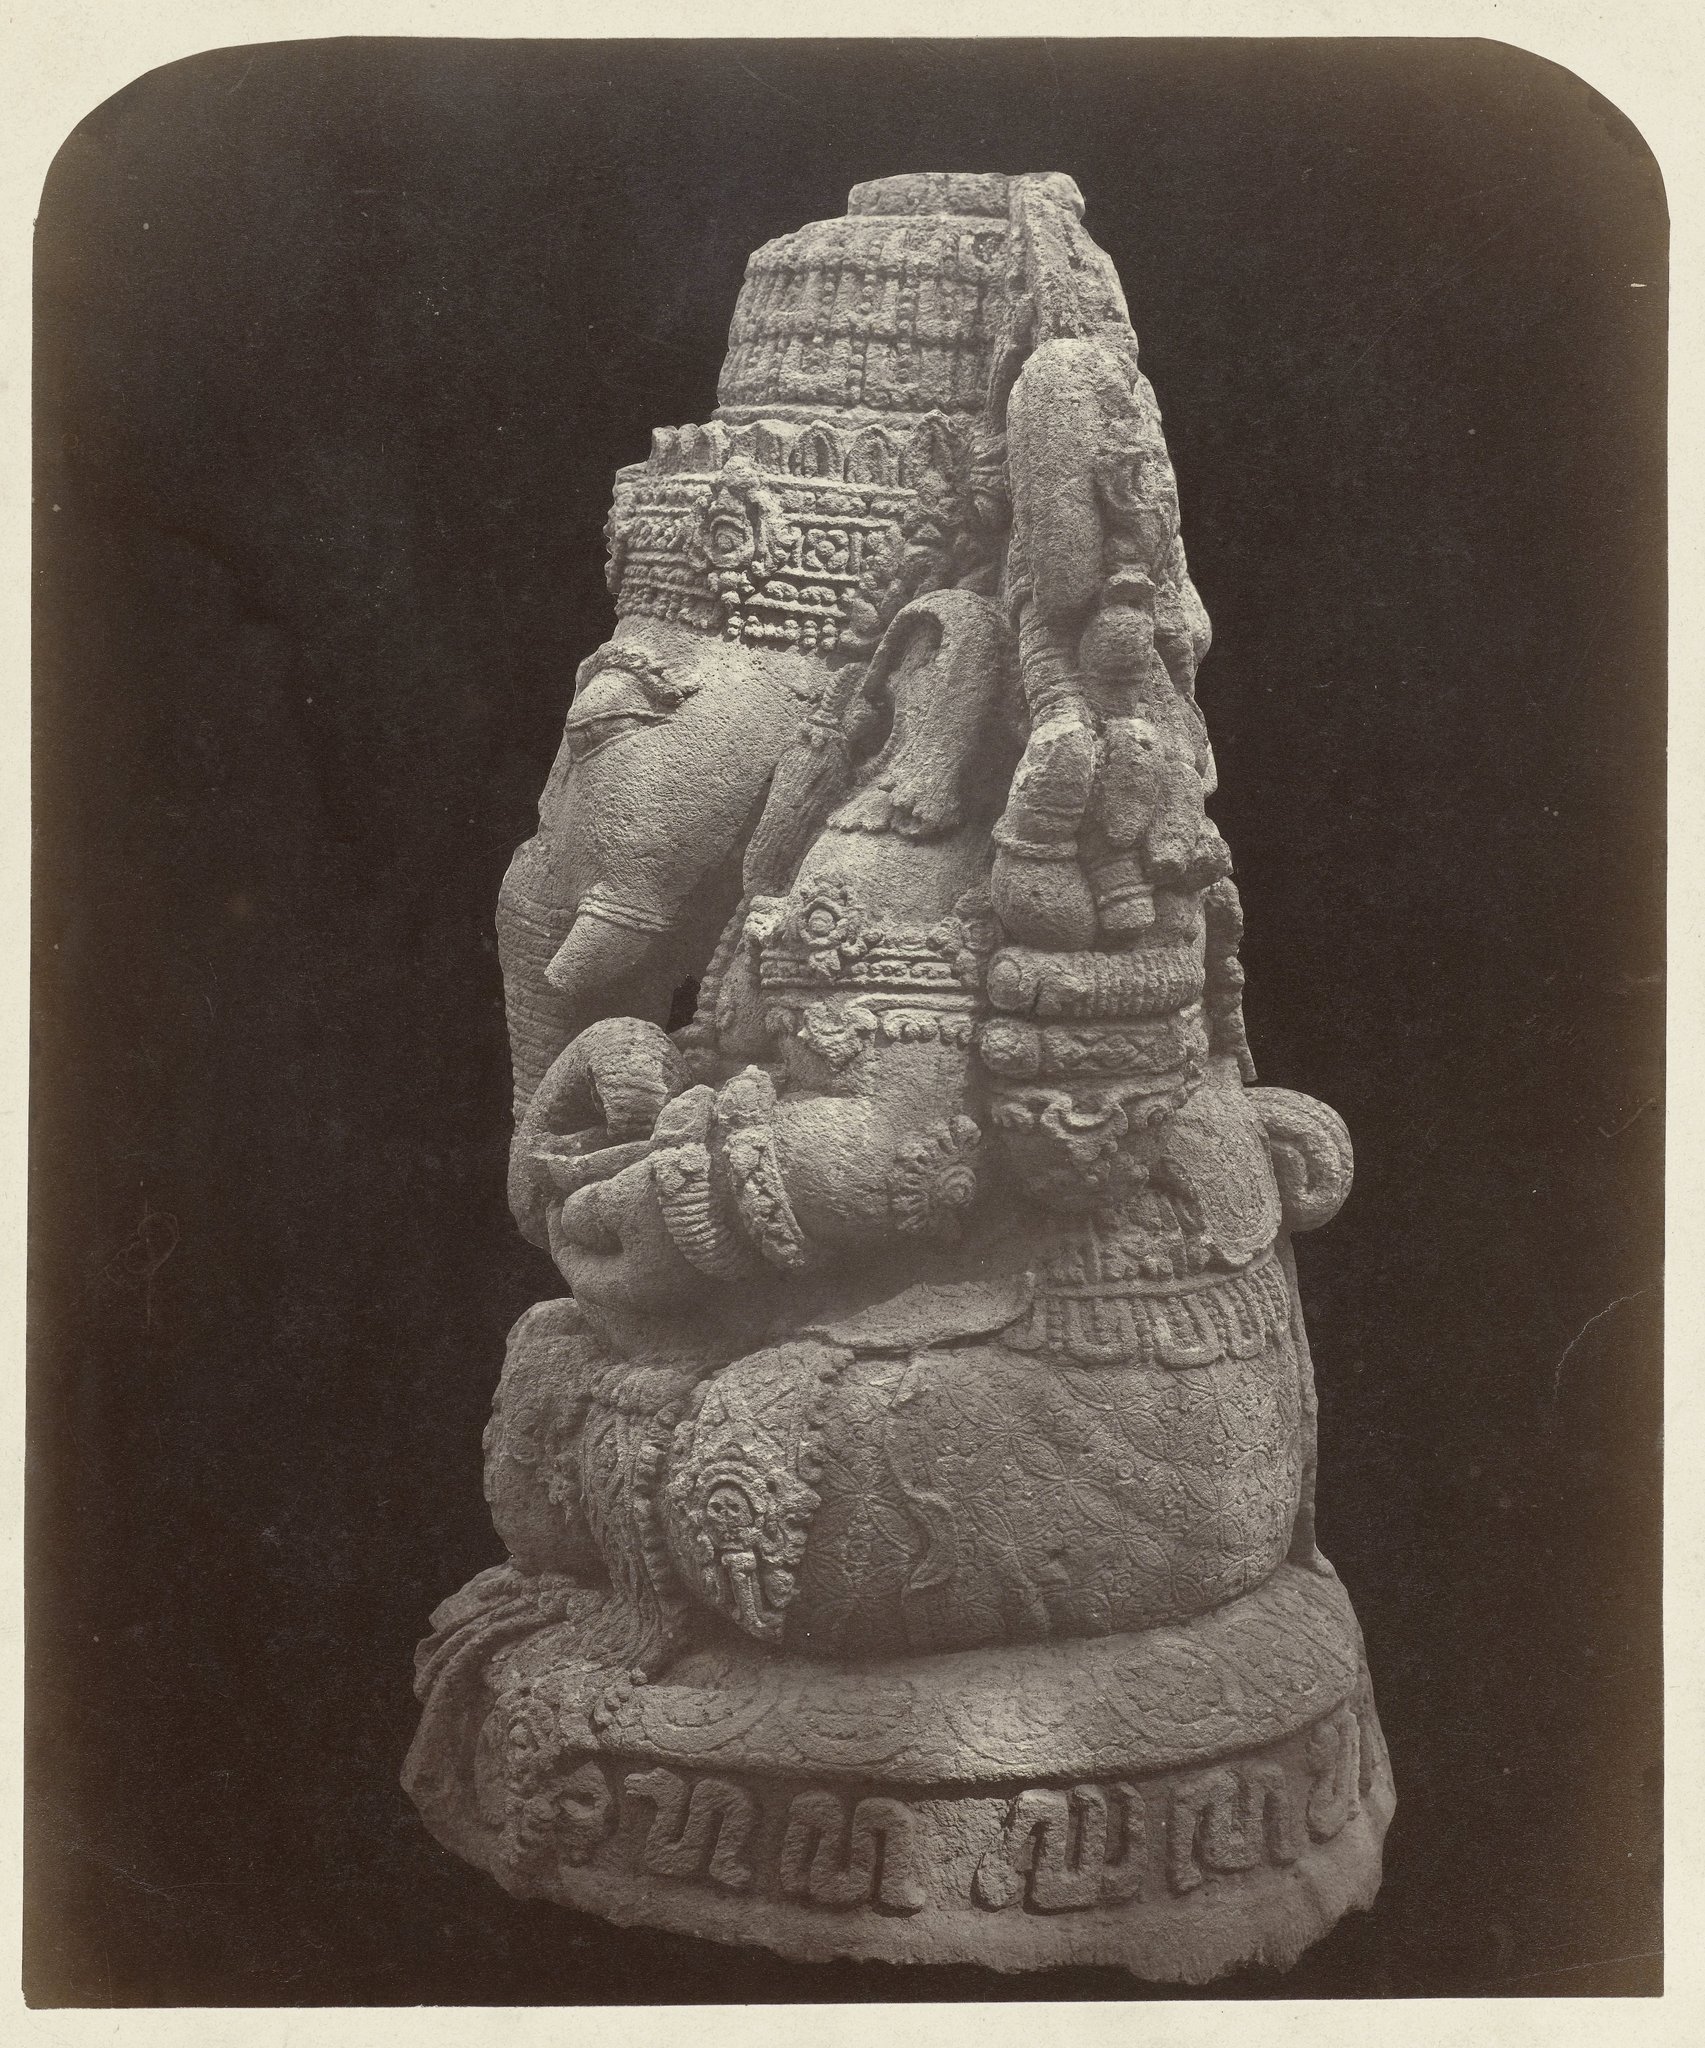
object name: photograph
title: Profile of the same Ganesha statue, pendopo pavilion. Boro, Blitar district, East Java province, 1219-1259 AD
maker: isidore kinsbergen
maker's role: fotograaf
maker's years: 1821-1905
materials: cardboard, paper, photographic support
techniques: albumen print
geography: java